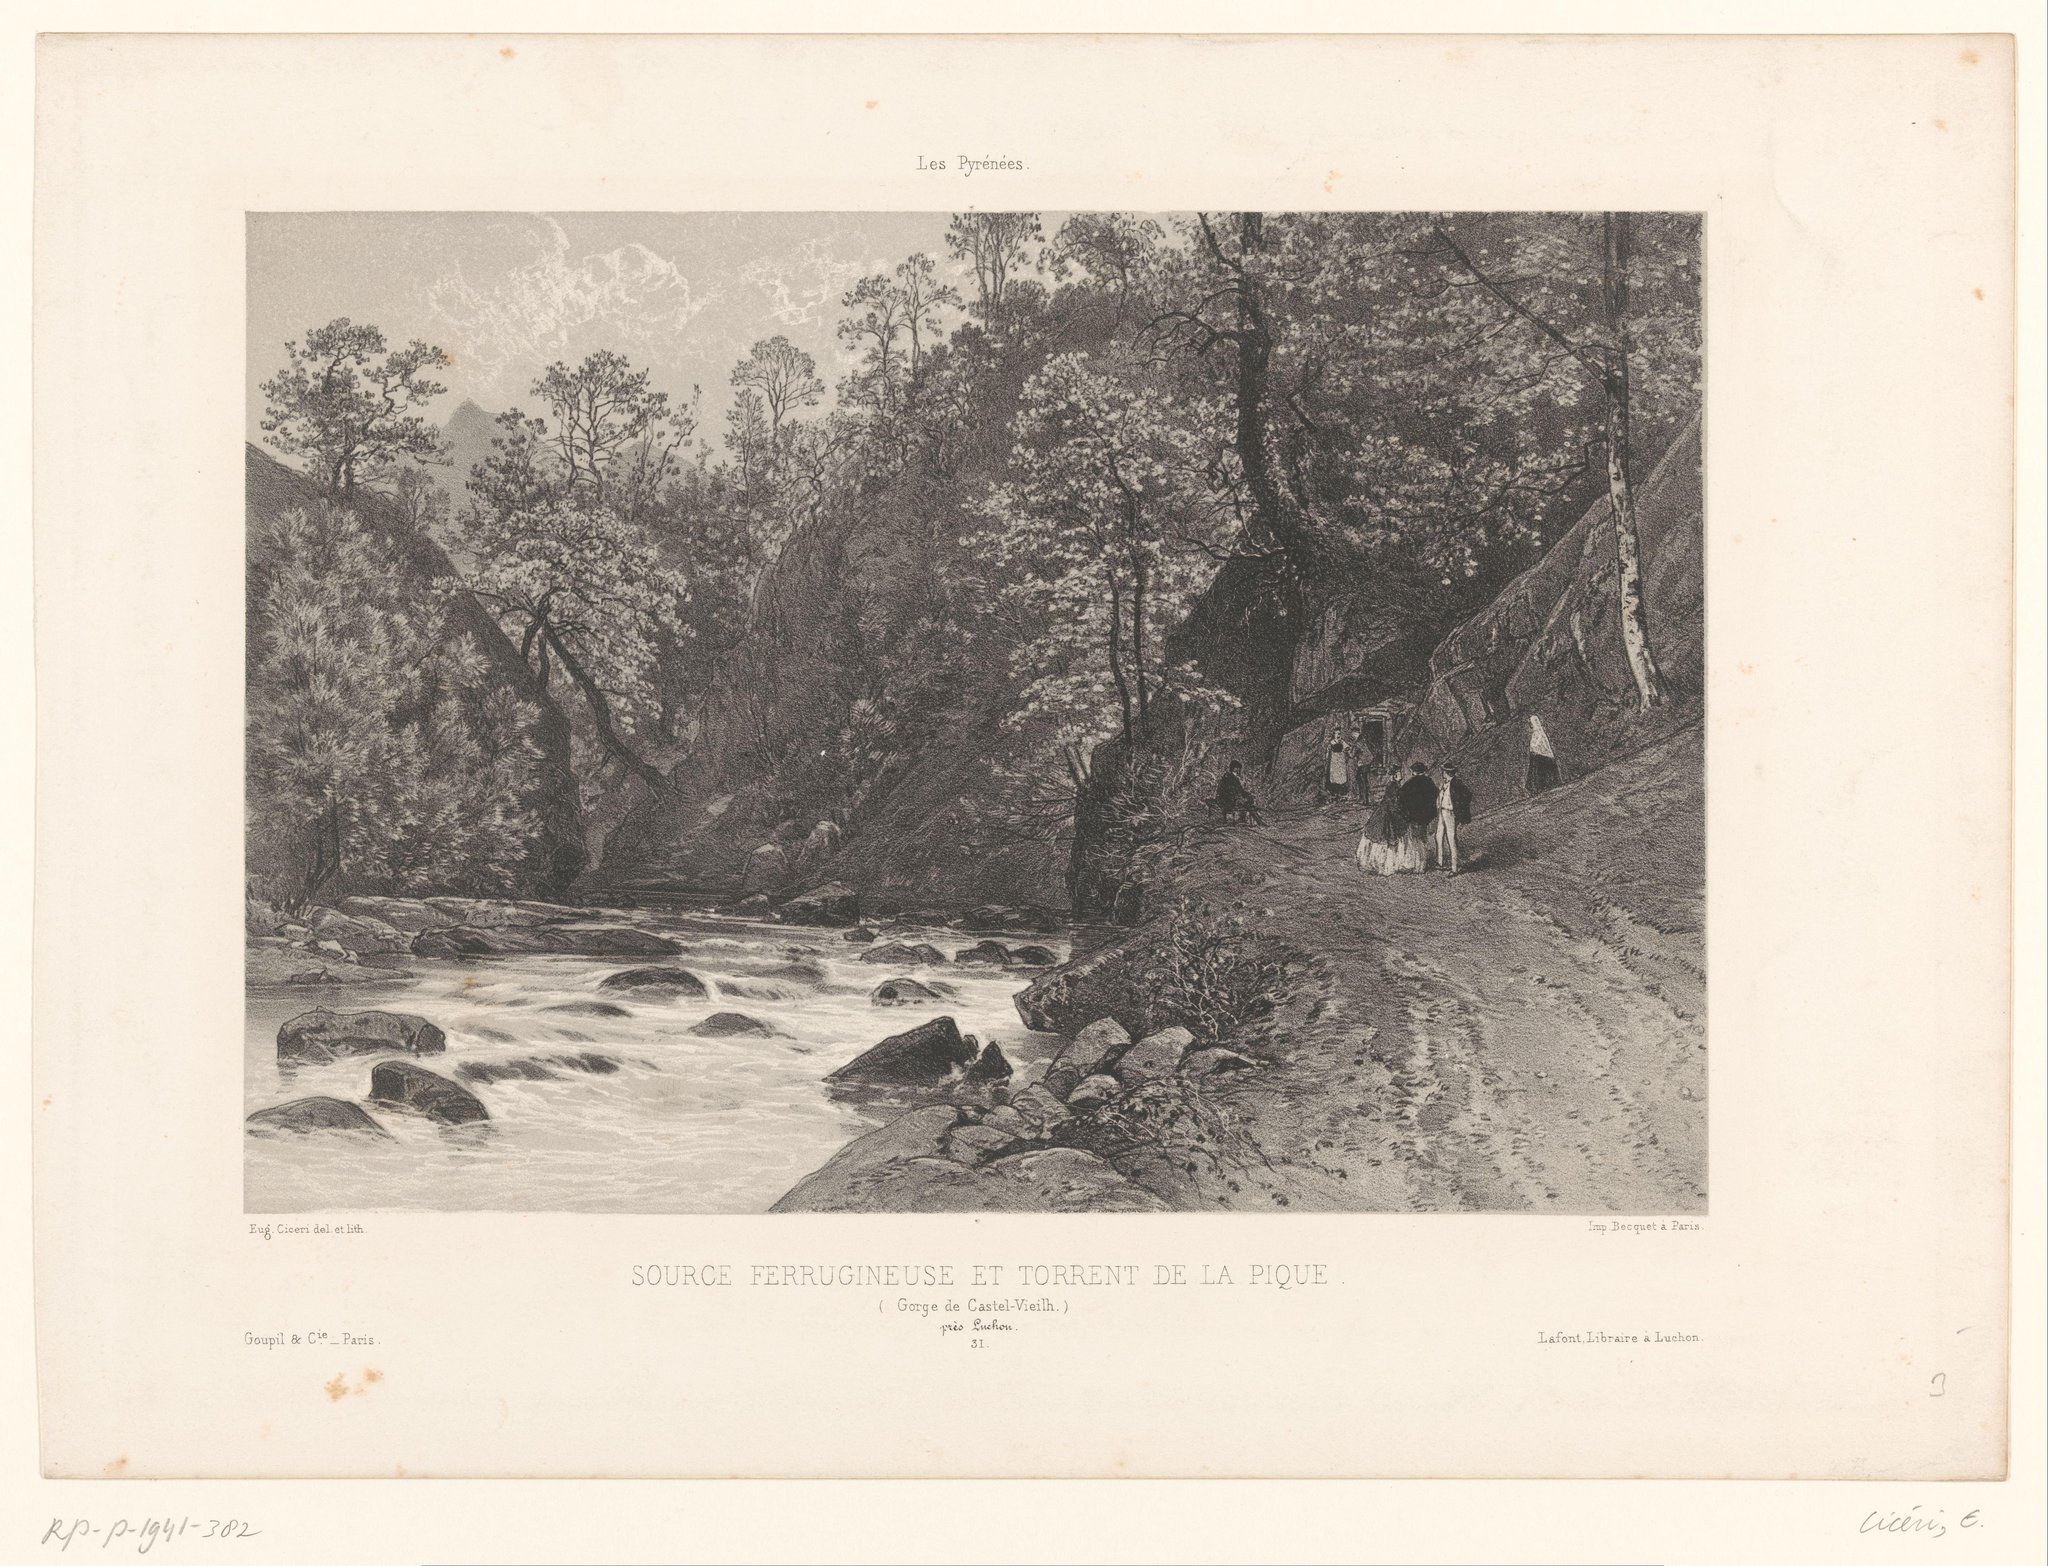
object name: print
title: Gezichten in de Pyreneeën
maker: eugène cicéri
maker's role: print maker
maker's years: 1813-1890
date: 1858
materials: paper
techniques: tone lithography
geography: paris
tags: brook, mountains (+ landscape with figures, staffage)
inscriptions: collector's mark: Lugt 2760, collector's mark: Lugt 2228a